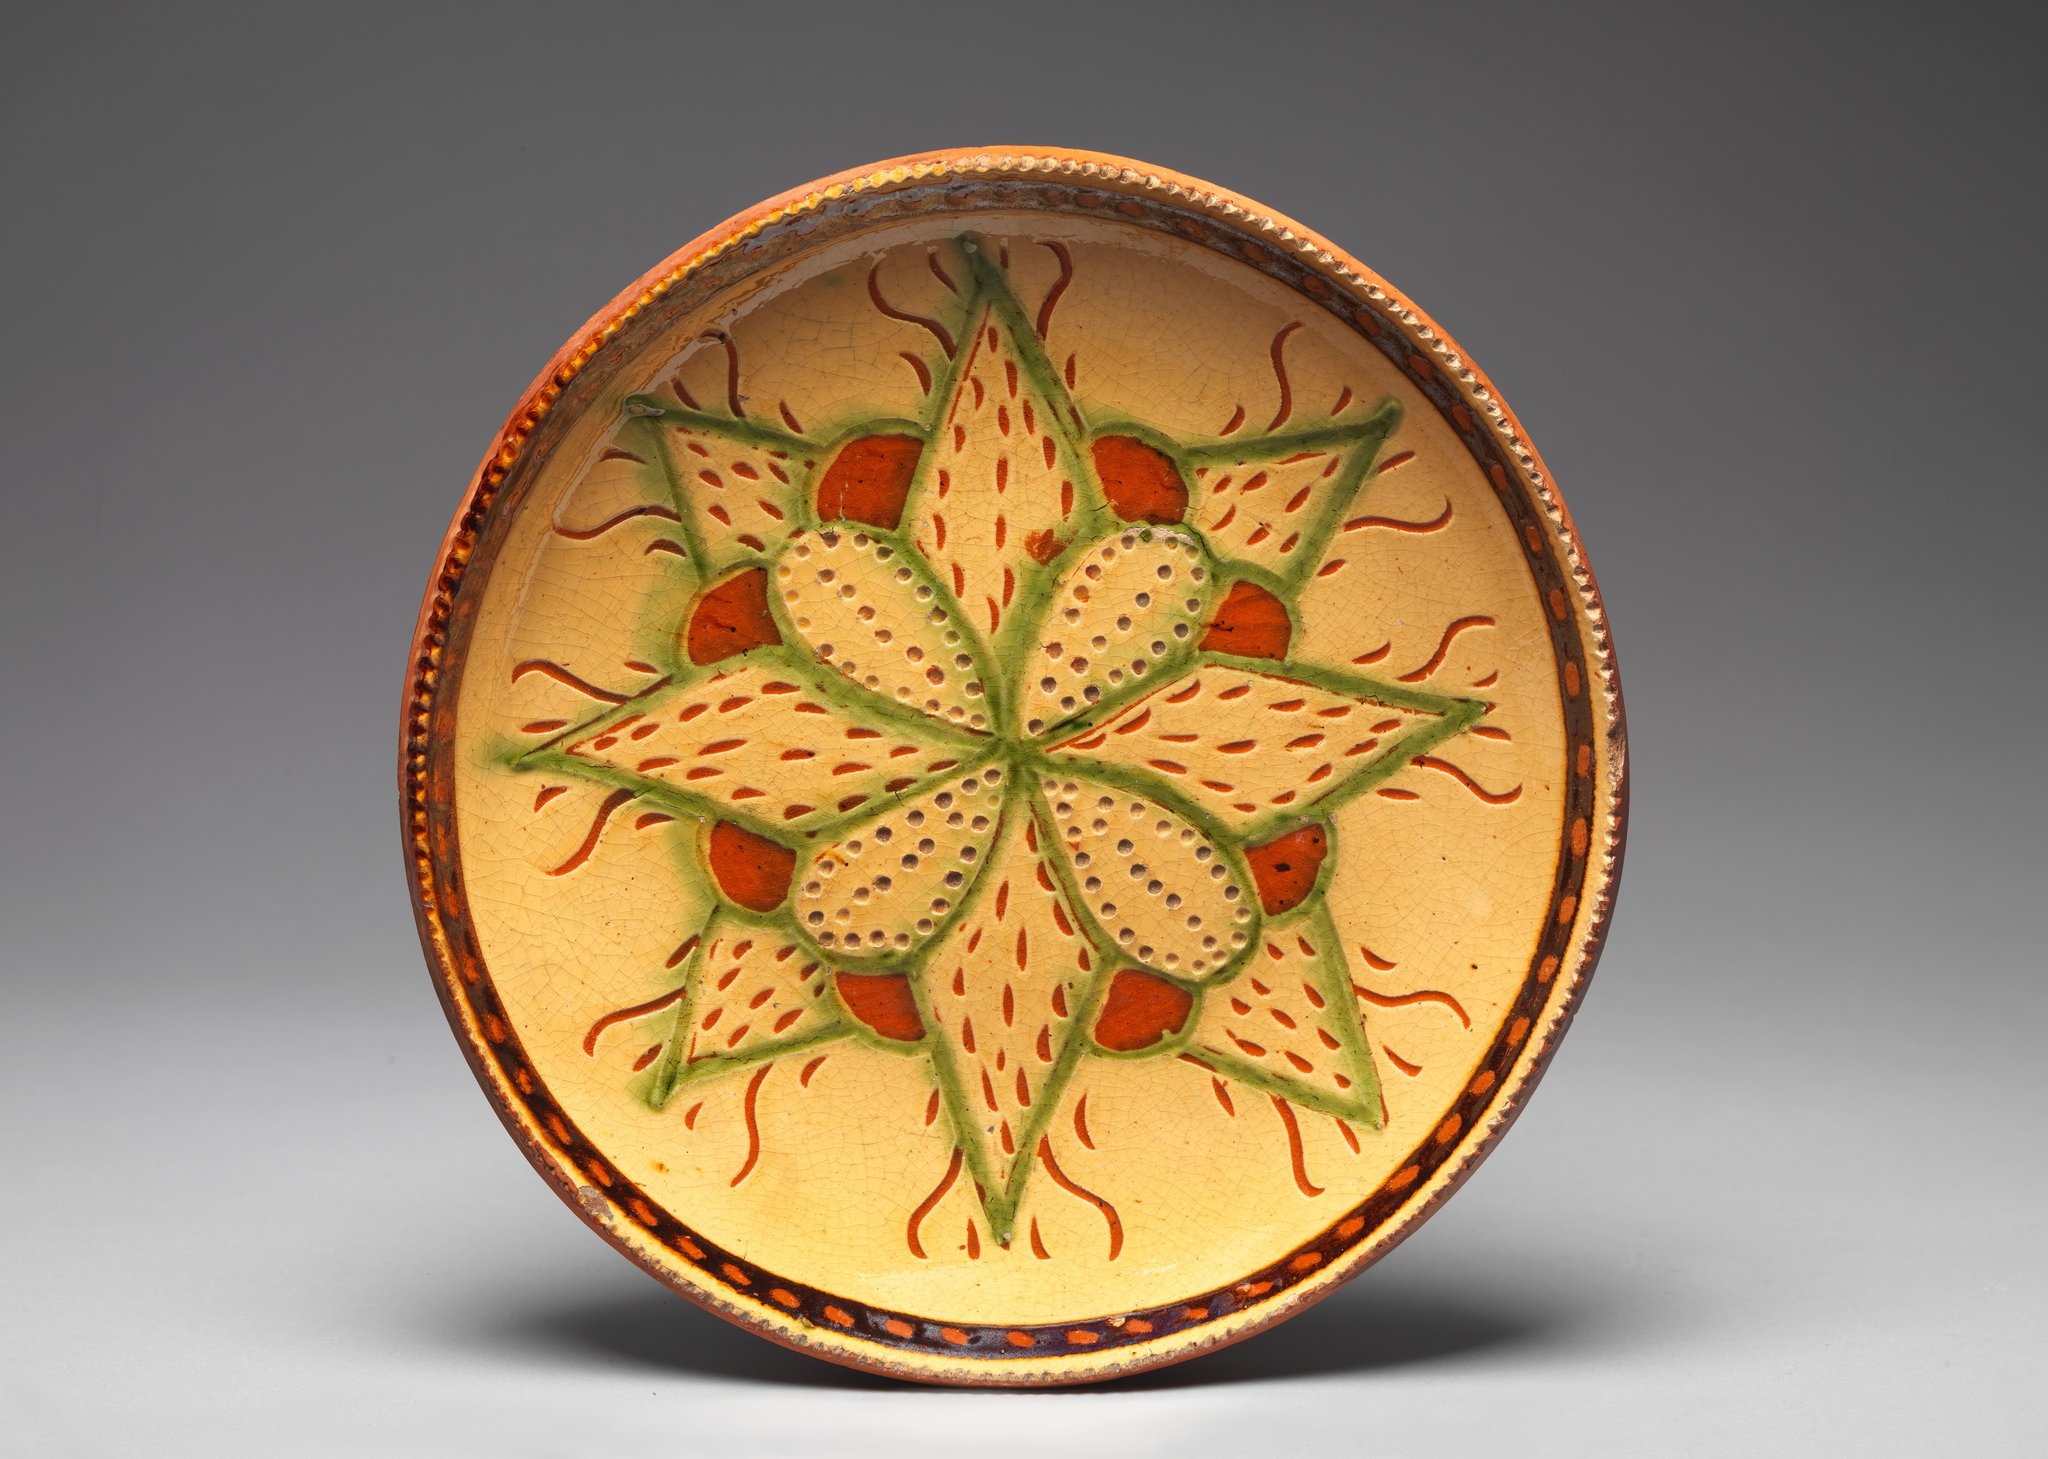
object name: plate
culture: american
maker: solomon grimm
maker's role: maker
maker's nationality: american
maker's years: 1787-1847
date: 1815-1825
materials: earthenware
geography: united states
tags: flowers